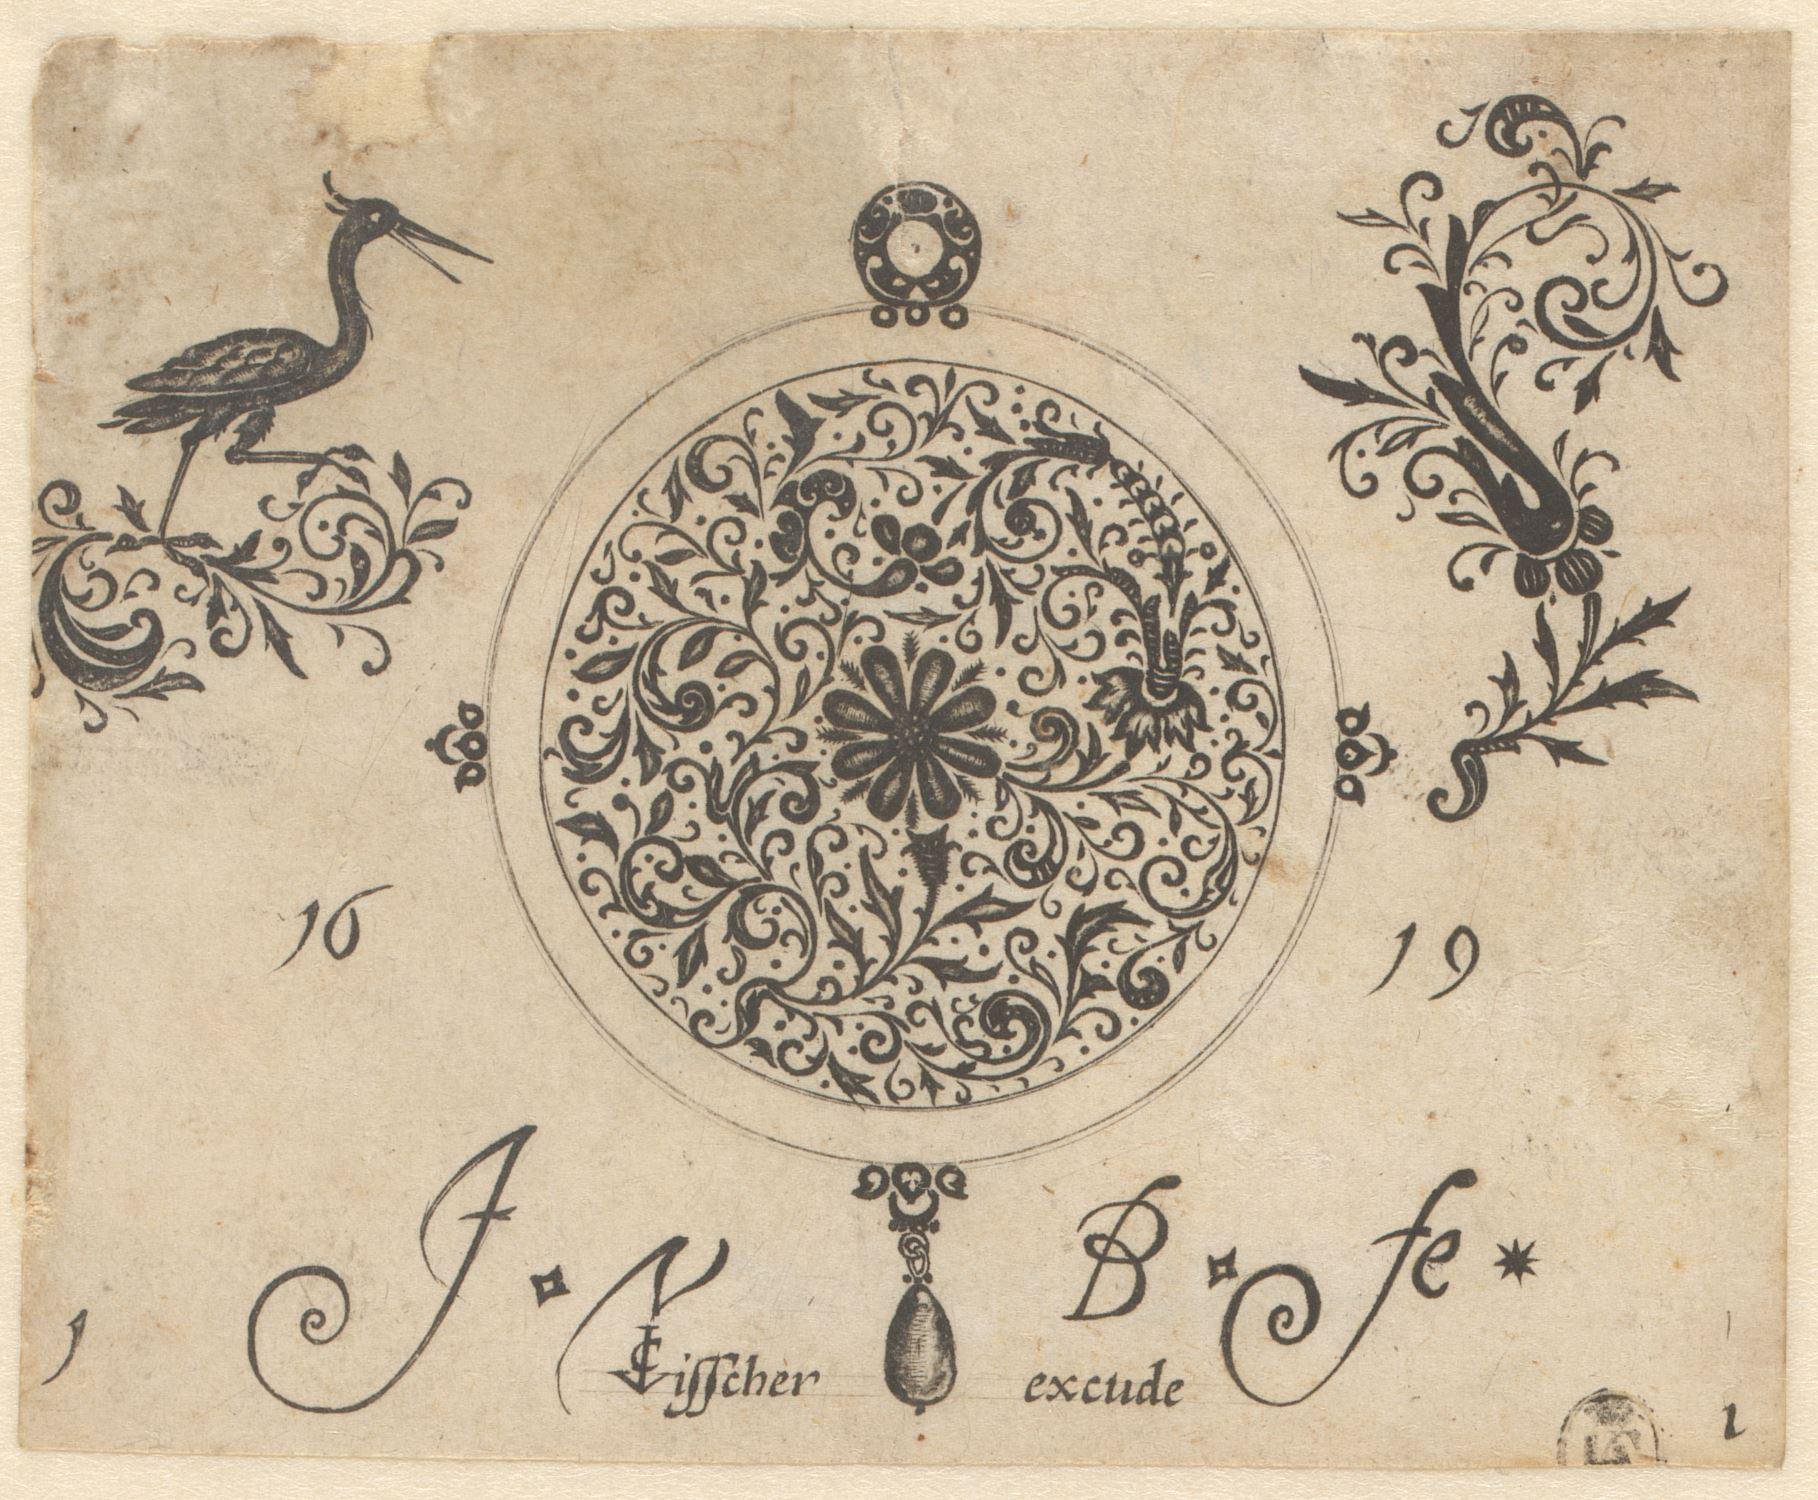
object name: print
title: Ontwerpen voor sieraden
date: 1619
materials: paper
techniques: engraving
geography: amsterdam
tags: ornaments ~ art, birds, ornaments, jewels, foliage, tendrils, branches ~ ornament, flowers ~ ornament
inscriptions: collector's mark: Lugt 2760, number: ‘1’, signature: ‘J.vB. fe.’, signature and date: ‘1619 / CI Visscher excude’, collector's mark: Lugt 972, collector's mark: Lugt 2228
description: Een blad uit een serie van ontwerpen voor sieraden.